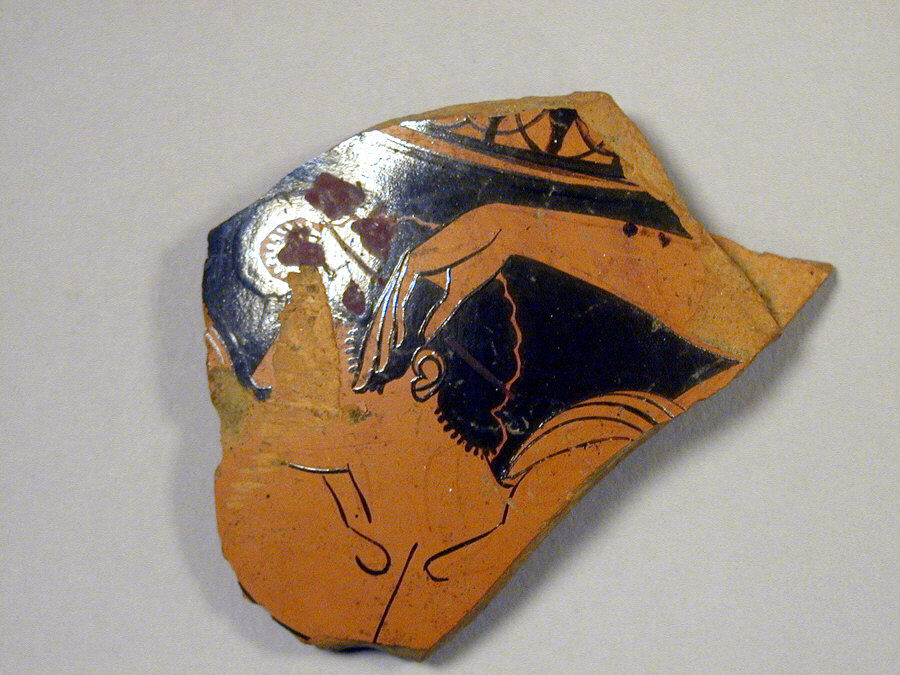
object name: pelike, fragmentary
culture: greek, attic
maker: euthymides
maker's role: artist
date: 520 BCE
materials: terracotta